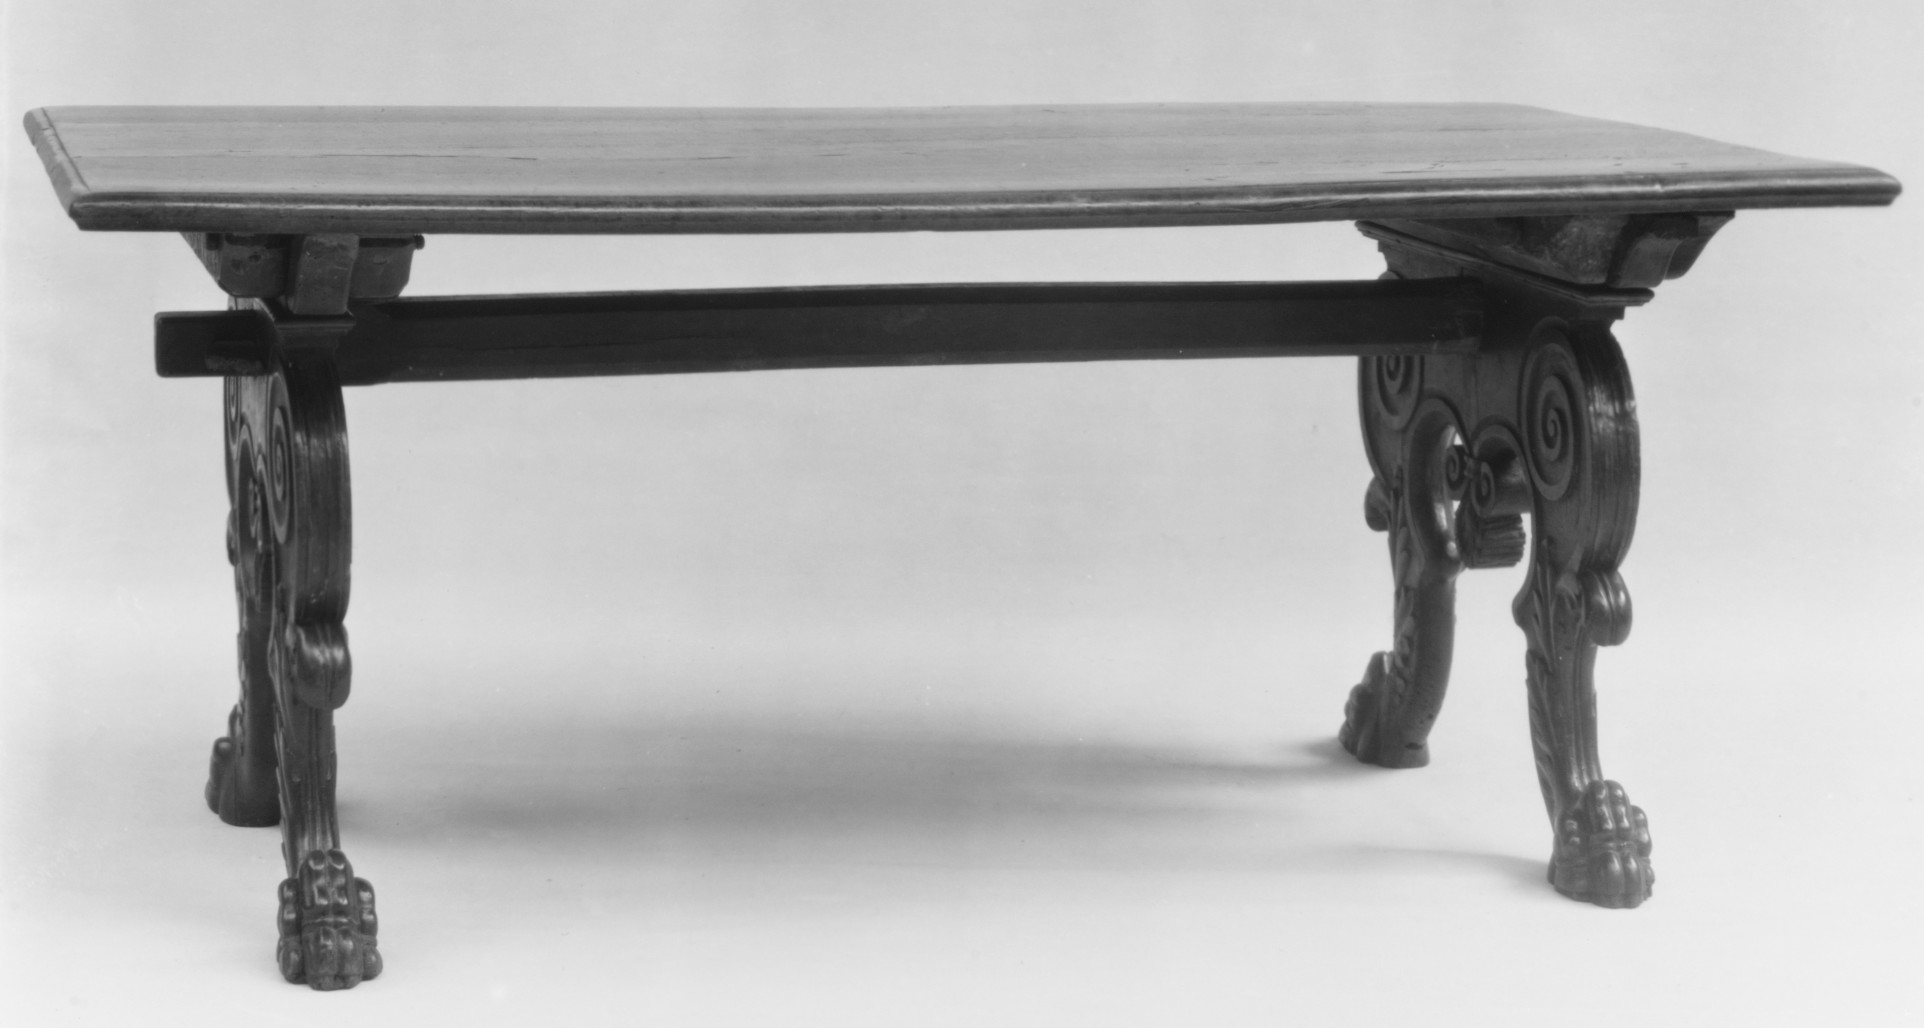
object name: table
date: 1501-1600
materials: wood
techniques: carving